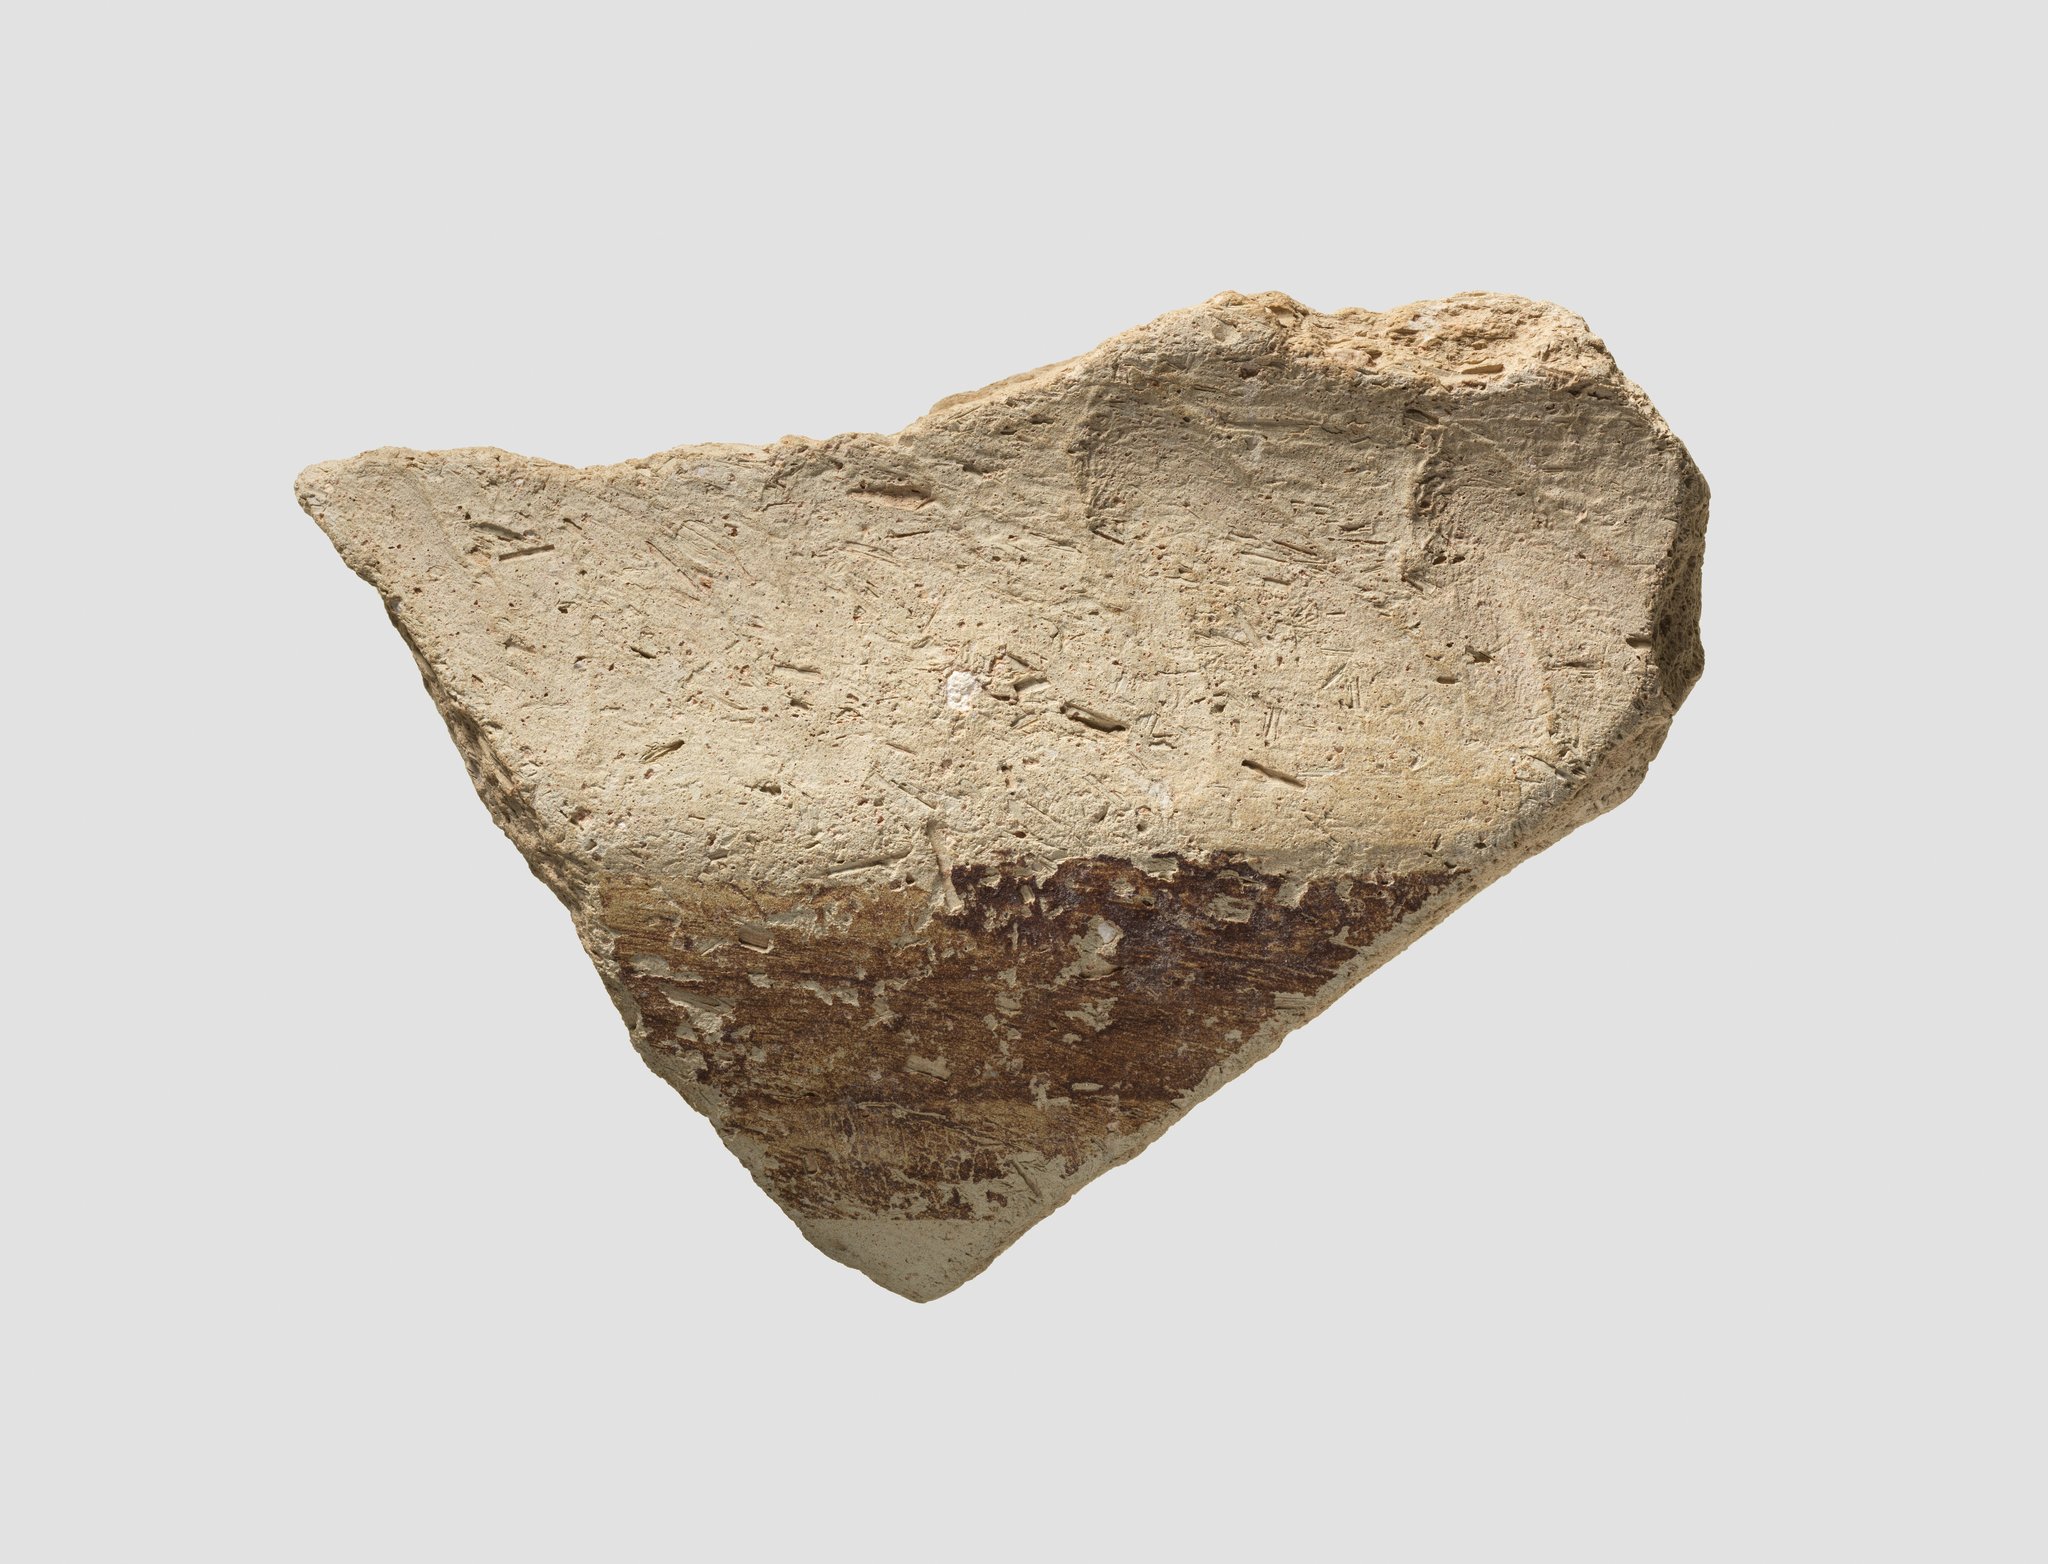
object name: jar or bowl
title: Carinated jar or bowl sherd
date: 2000-1668 BCE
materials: ceramic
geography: mesopotamia